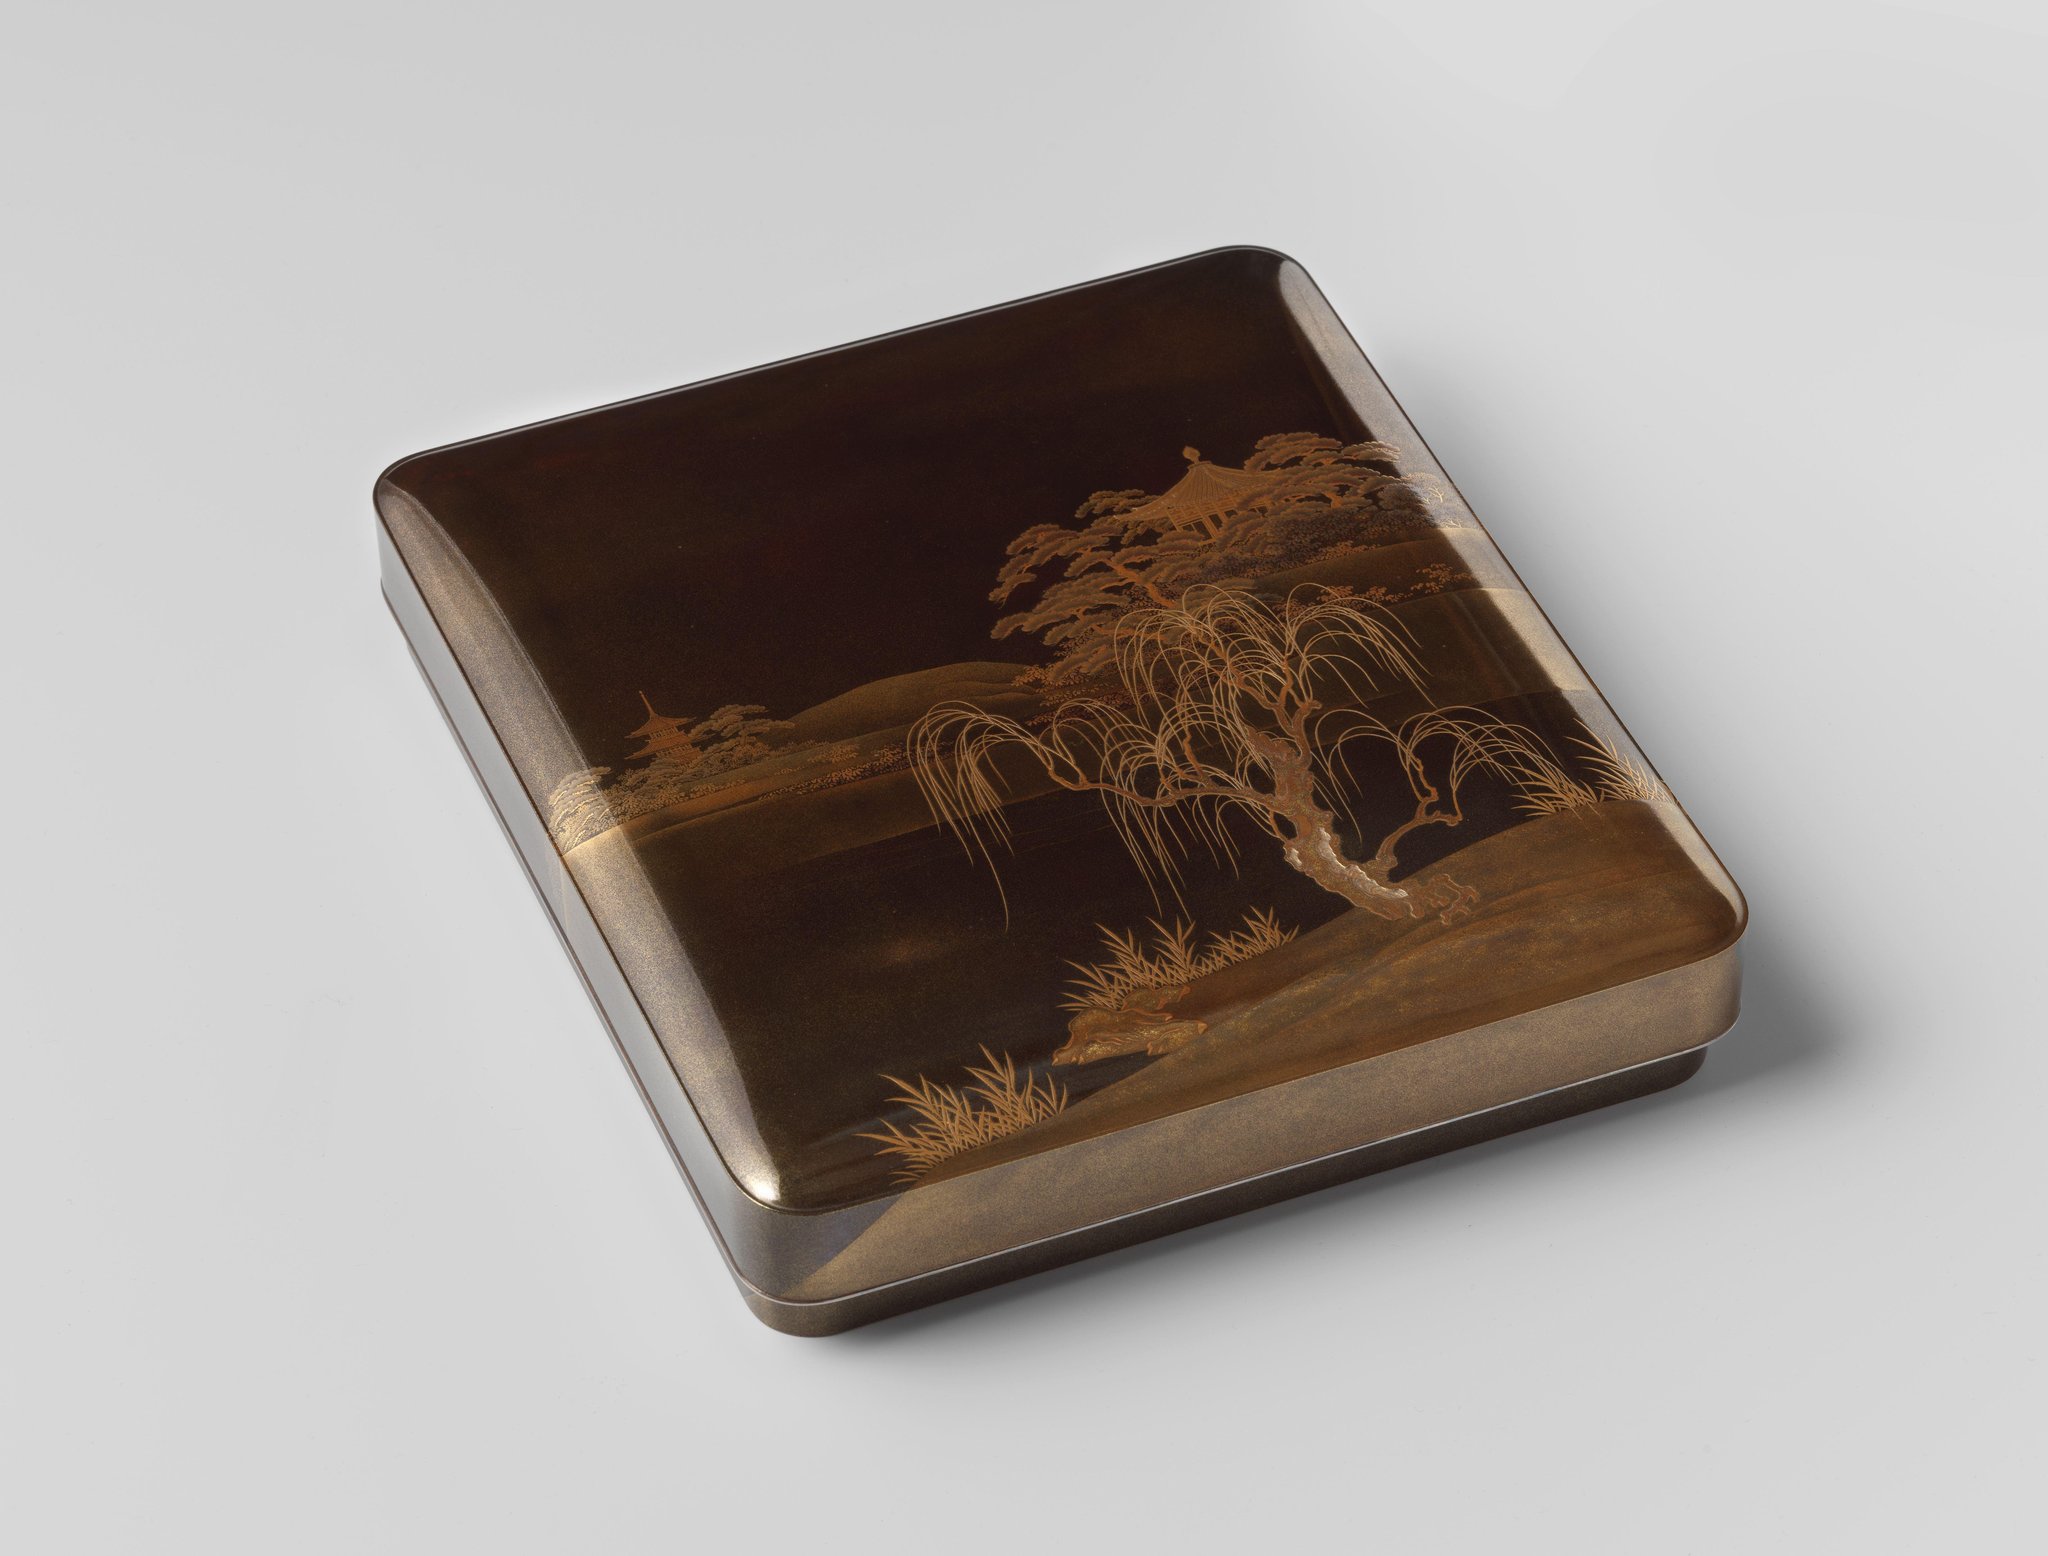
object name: schrijfdoos, schrijfcassette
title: Writing box with a view of Sarusawa Pond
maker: funabashi shūmin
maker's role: lacquerer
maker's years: 1859-1931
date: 1905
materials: lacquer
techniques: lacquer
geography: japan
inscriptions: signature: ‘船橋舟珉’, inscription: ‘明治三十八年十二月九日 凱旋 聖上陛下親ㇰ賜之’, inscription: ‘邦彦王謹記’, inscription: ‘御硯箱’, inscription: ‘四季山水之図’, seal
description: The moon is reflected in Sarusawa Pond in the ancient Imperial capital of Nara. The weeping willow seems to be the protagonist. On the opposite side are the buildings of Kofukuji Temple. Depth is achieved by means of varying degrees of relief in the lacquer. Prince Kuni Kuniyoshi received this writing box as a gift from Emperor Meiji ingratitude for his service in the Russo-Japanese War of 1904-1905.